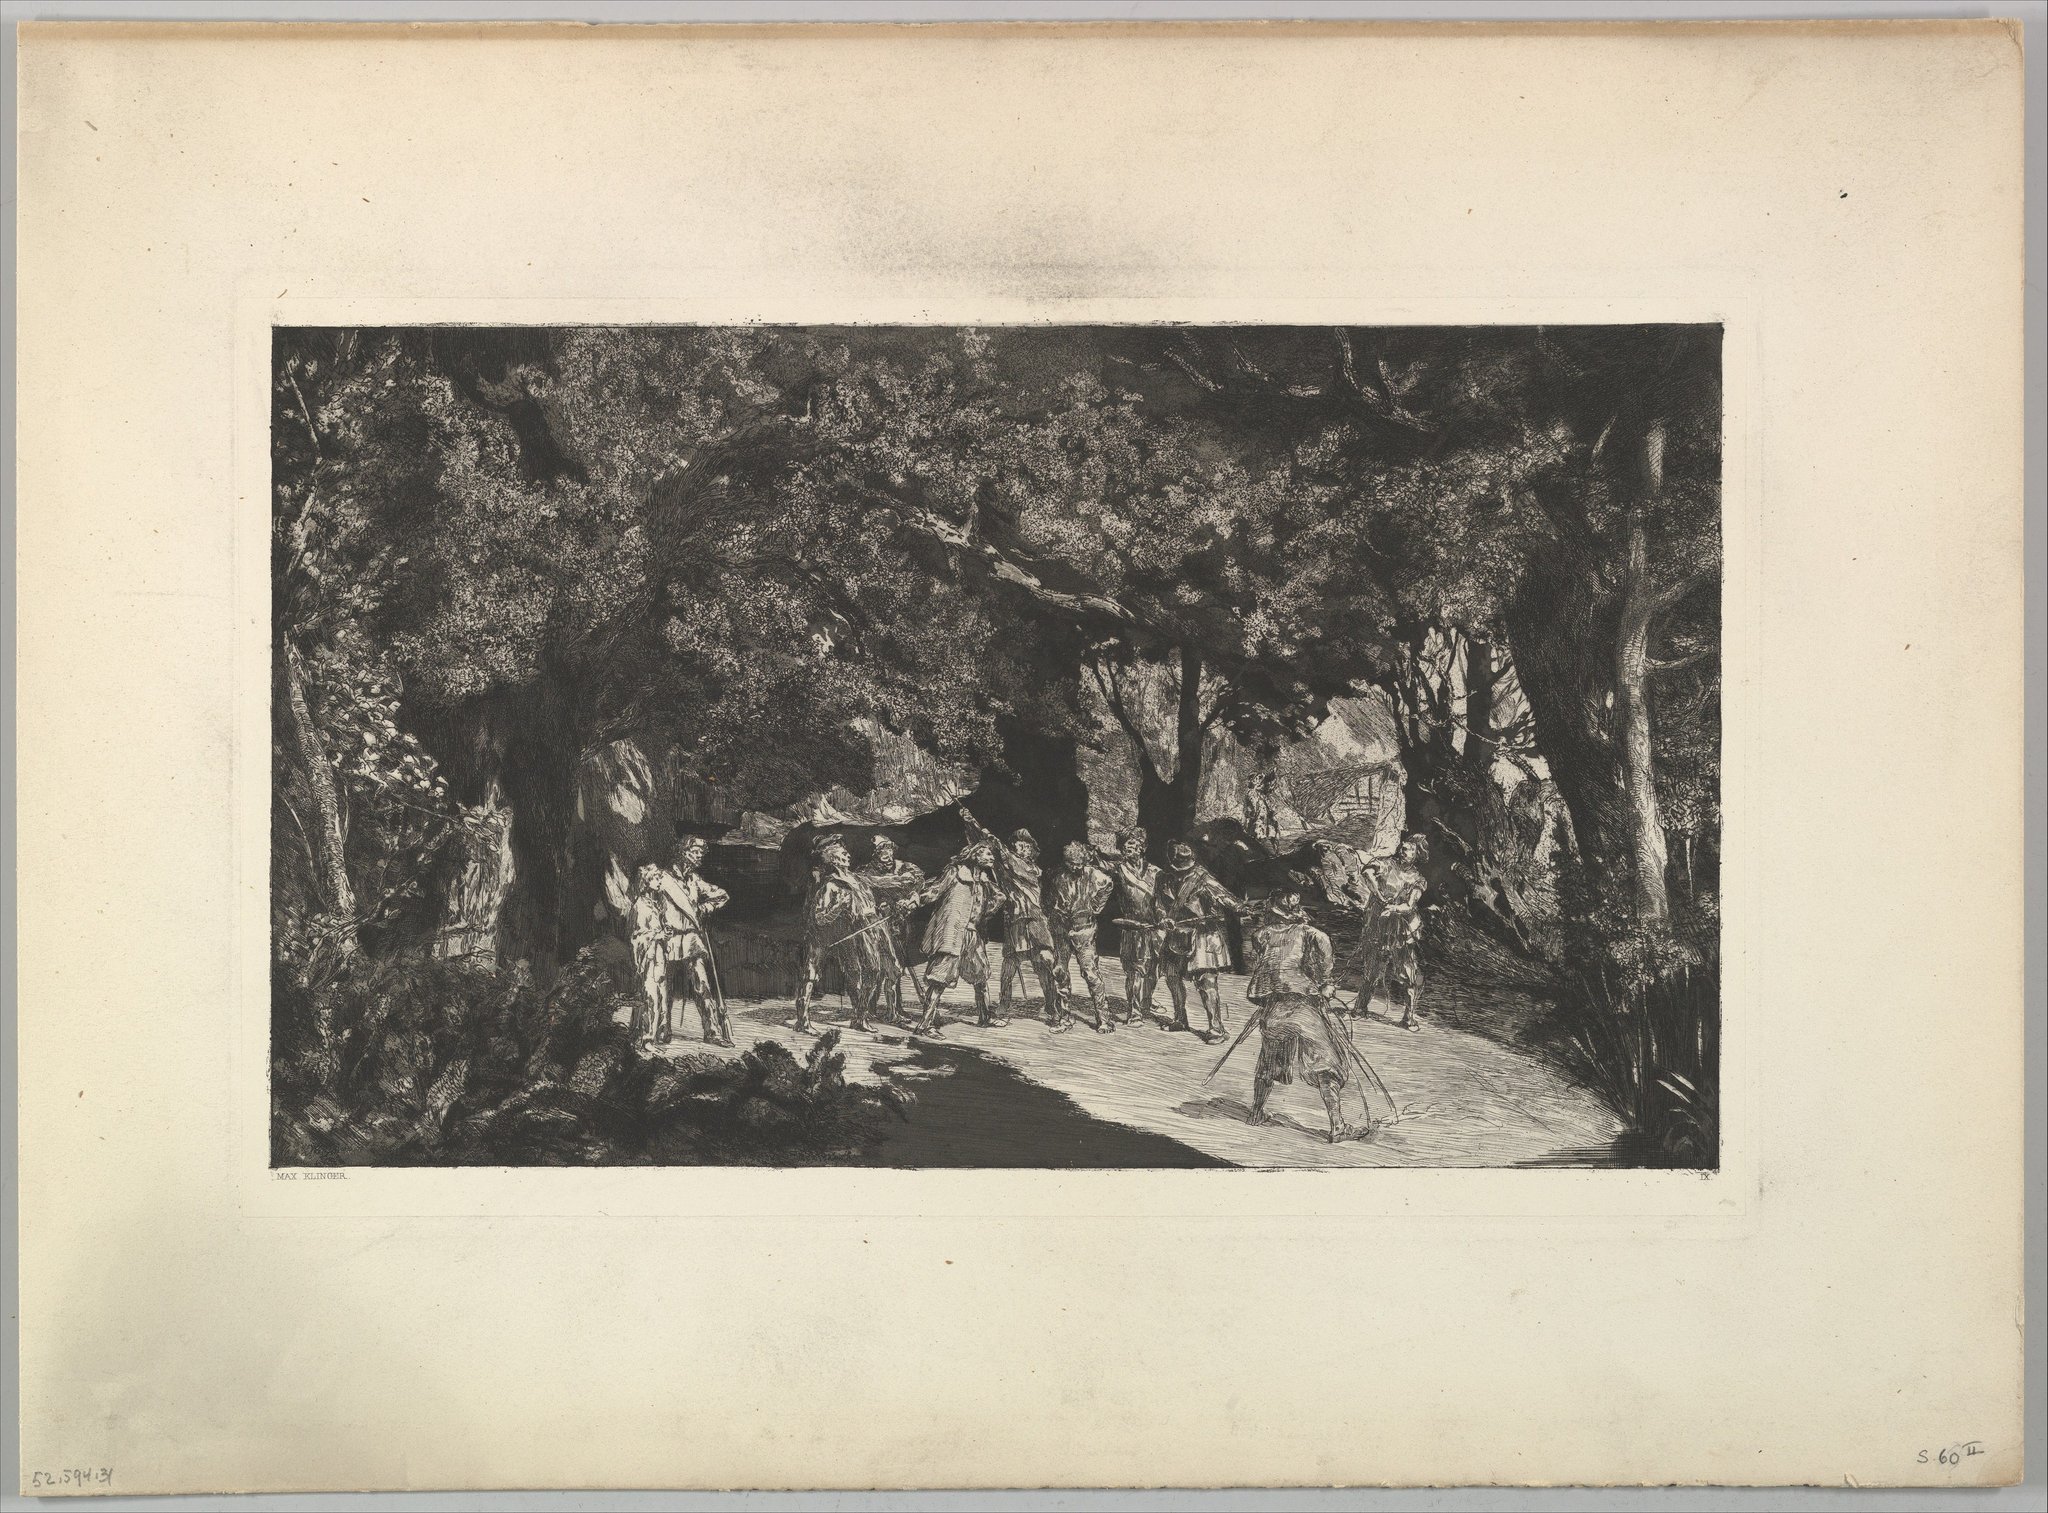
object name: print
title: Simplicius unter den Soldaten, from the series Intermezzi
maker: max klinger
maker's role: artist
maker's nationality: german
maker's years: 1857-1920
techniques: aquatint, printmaking, etching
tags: soldiers,men,trees